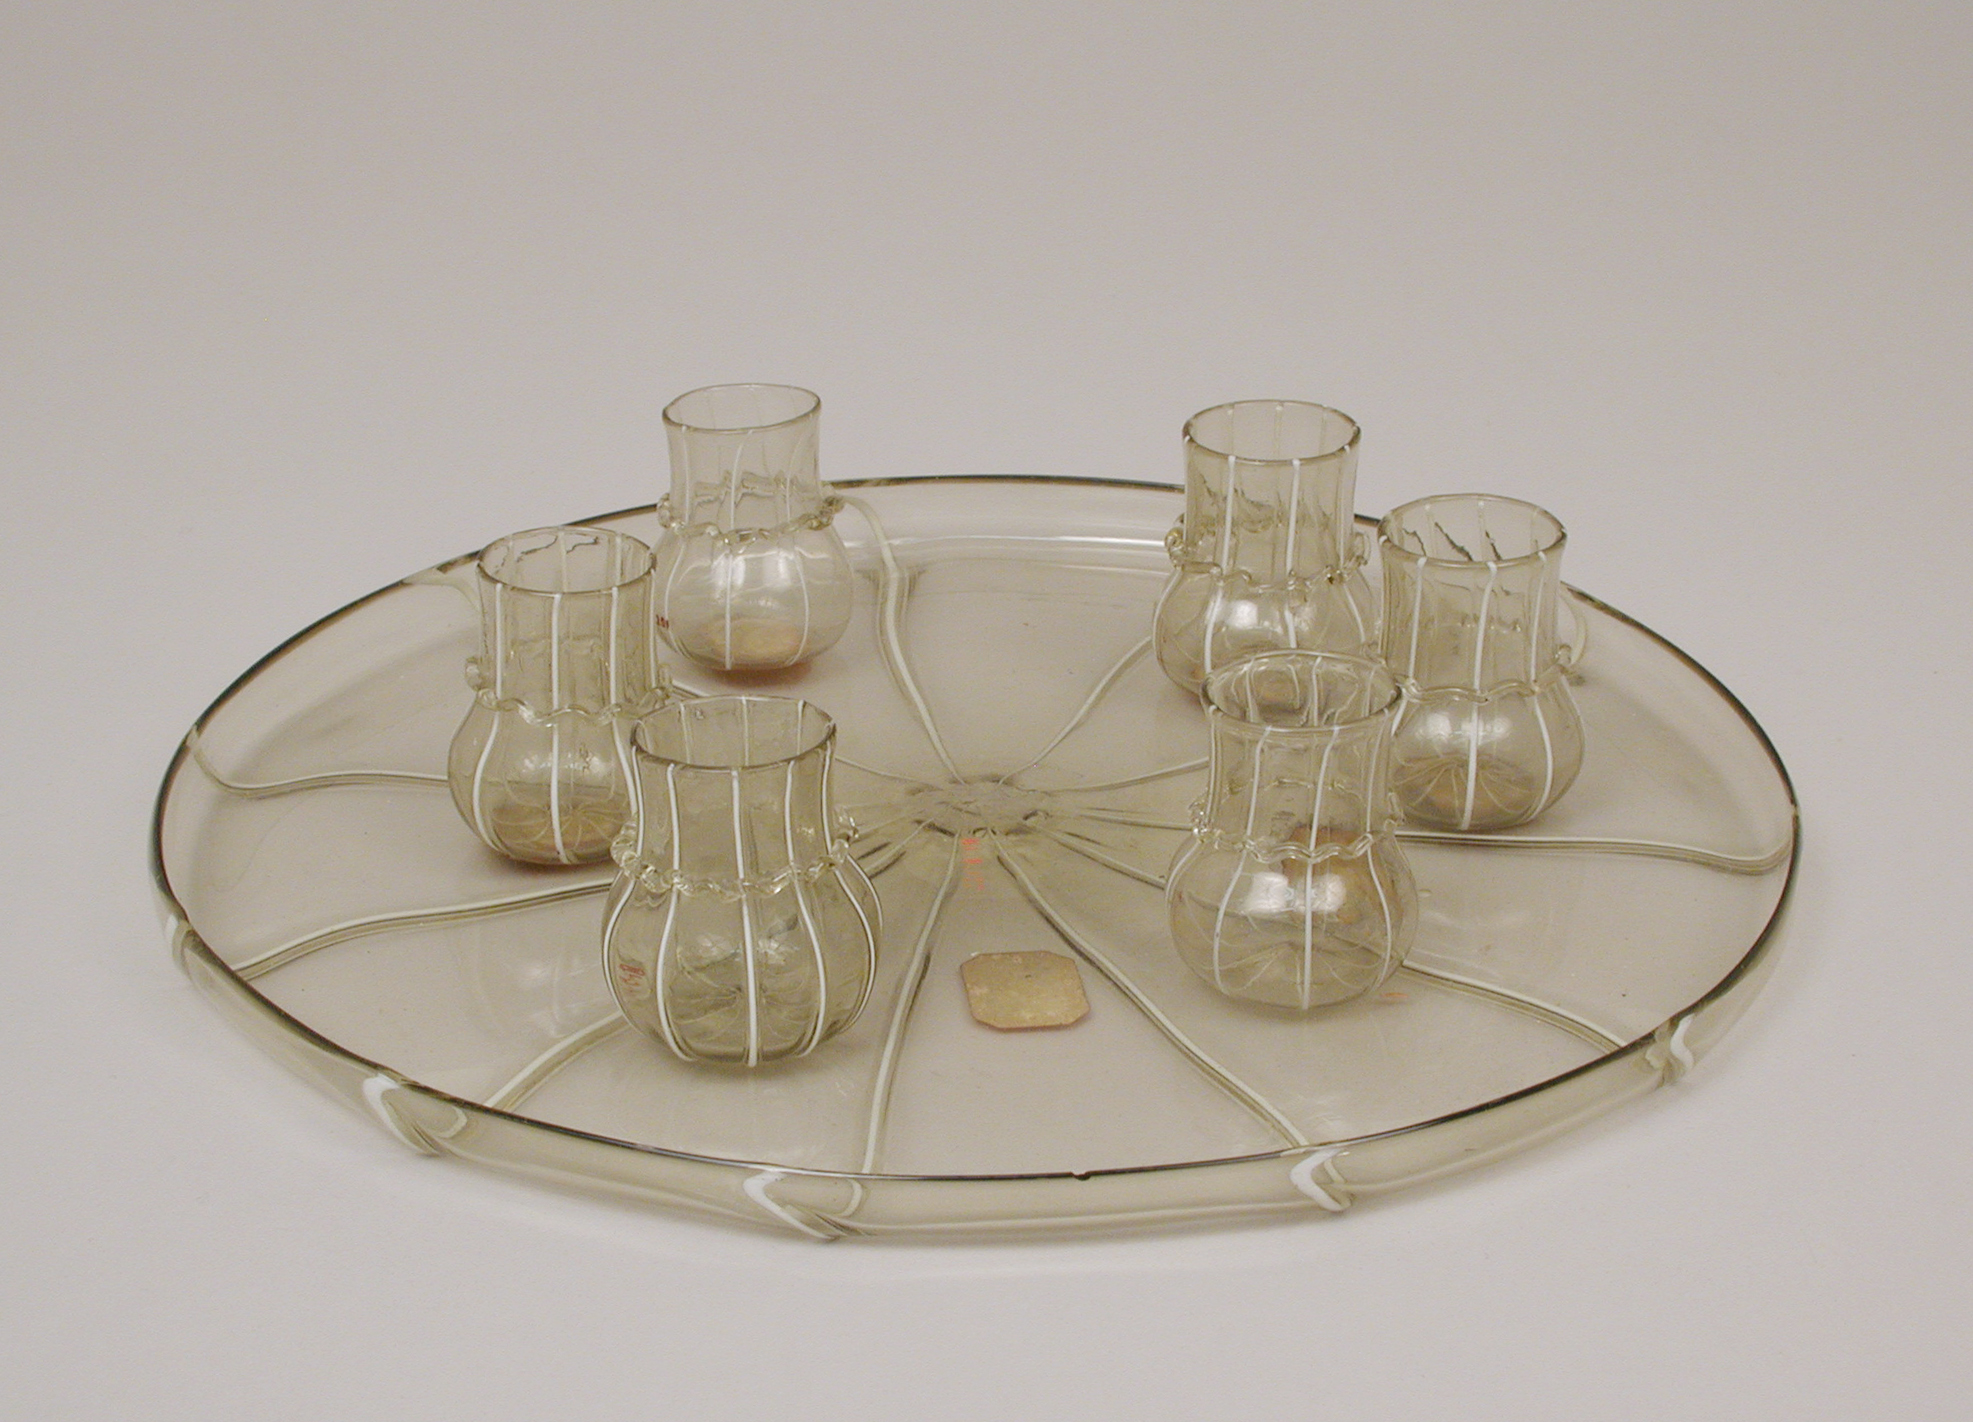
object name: schnapps glass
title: Schnapps glass (one of six)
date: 1801-1900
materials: glass